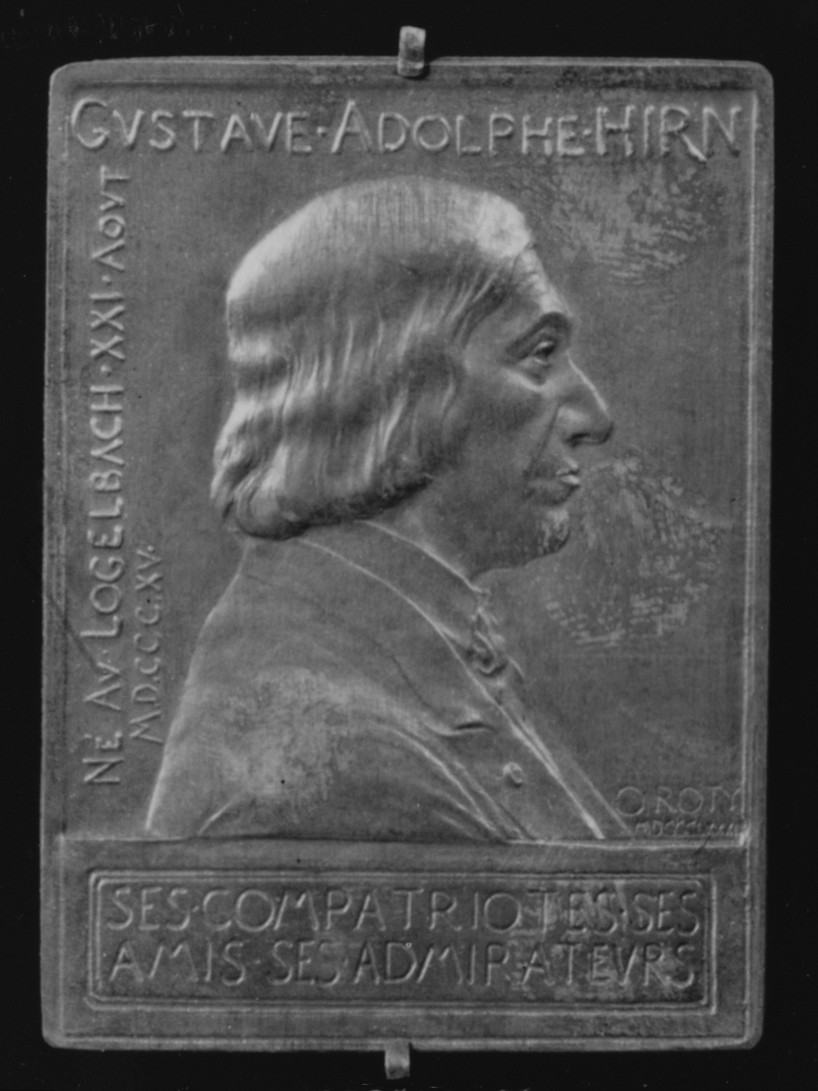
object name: plaquette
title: In Honor of Gustave Adolphe Hirn, Physicist (1815–1890)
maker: louis-oscar roty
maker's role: artist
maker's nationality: french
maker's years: 1846-1911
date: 1889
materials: bronze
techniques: silvered, struck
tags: men,profiles